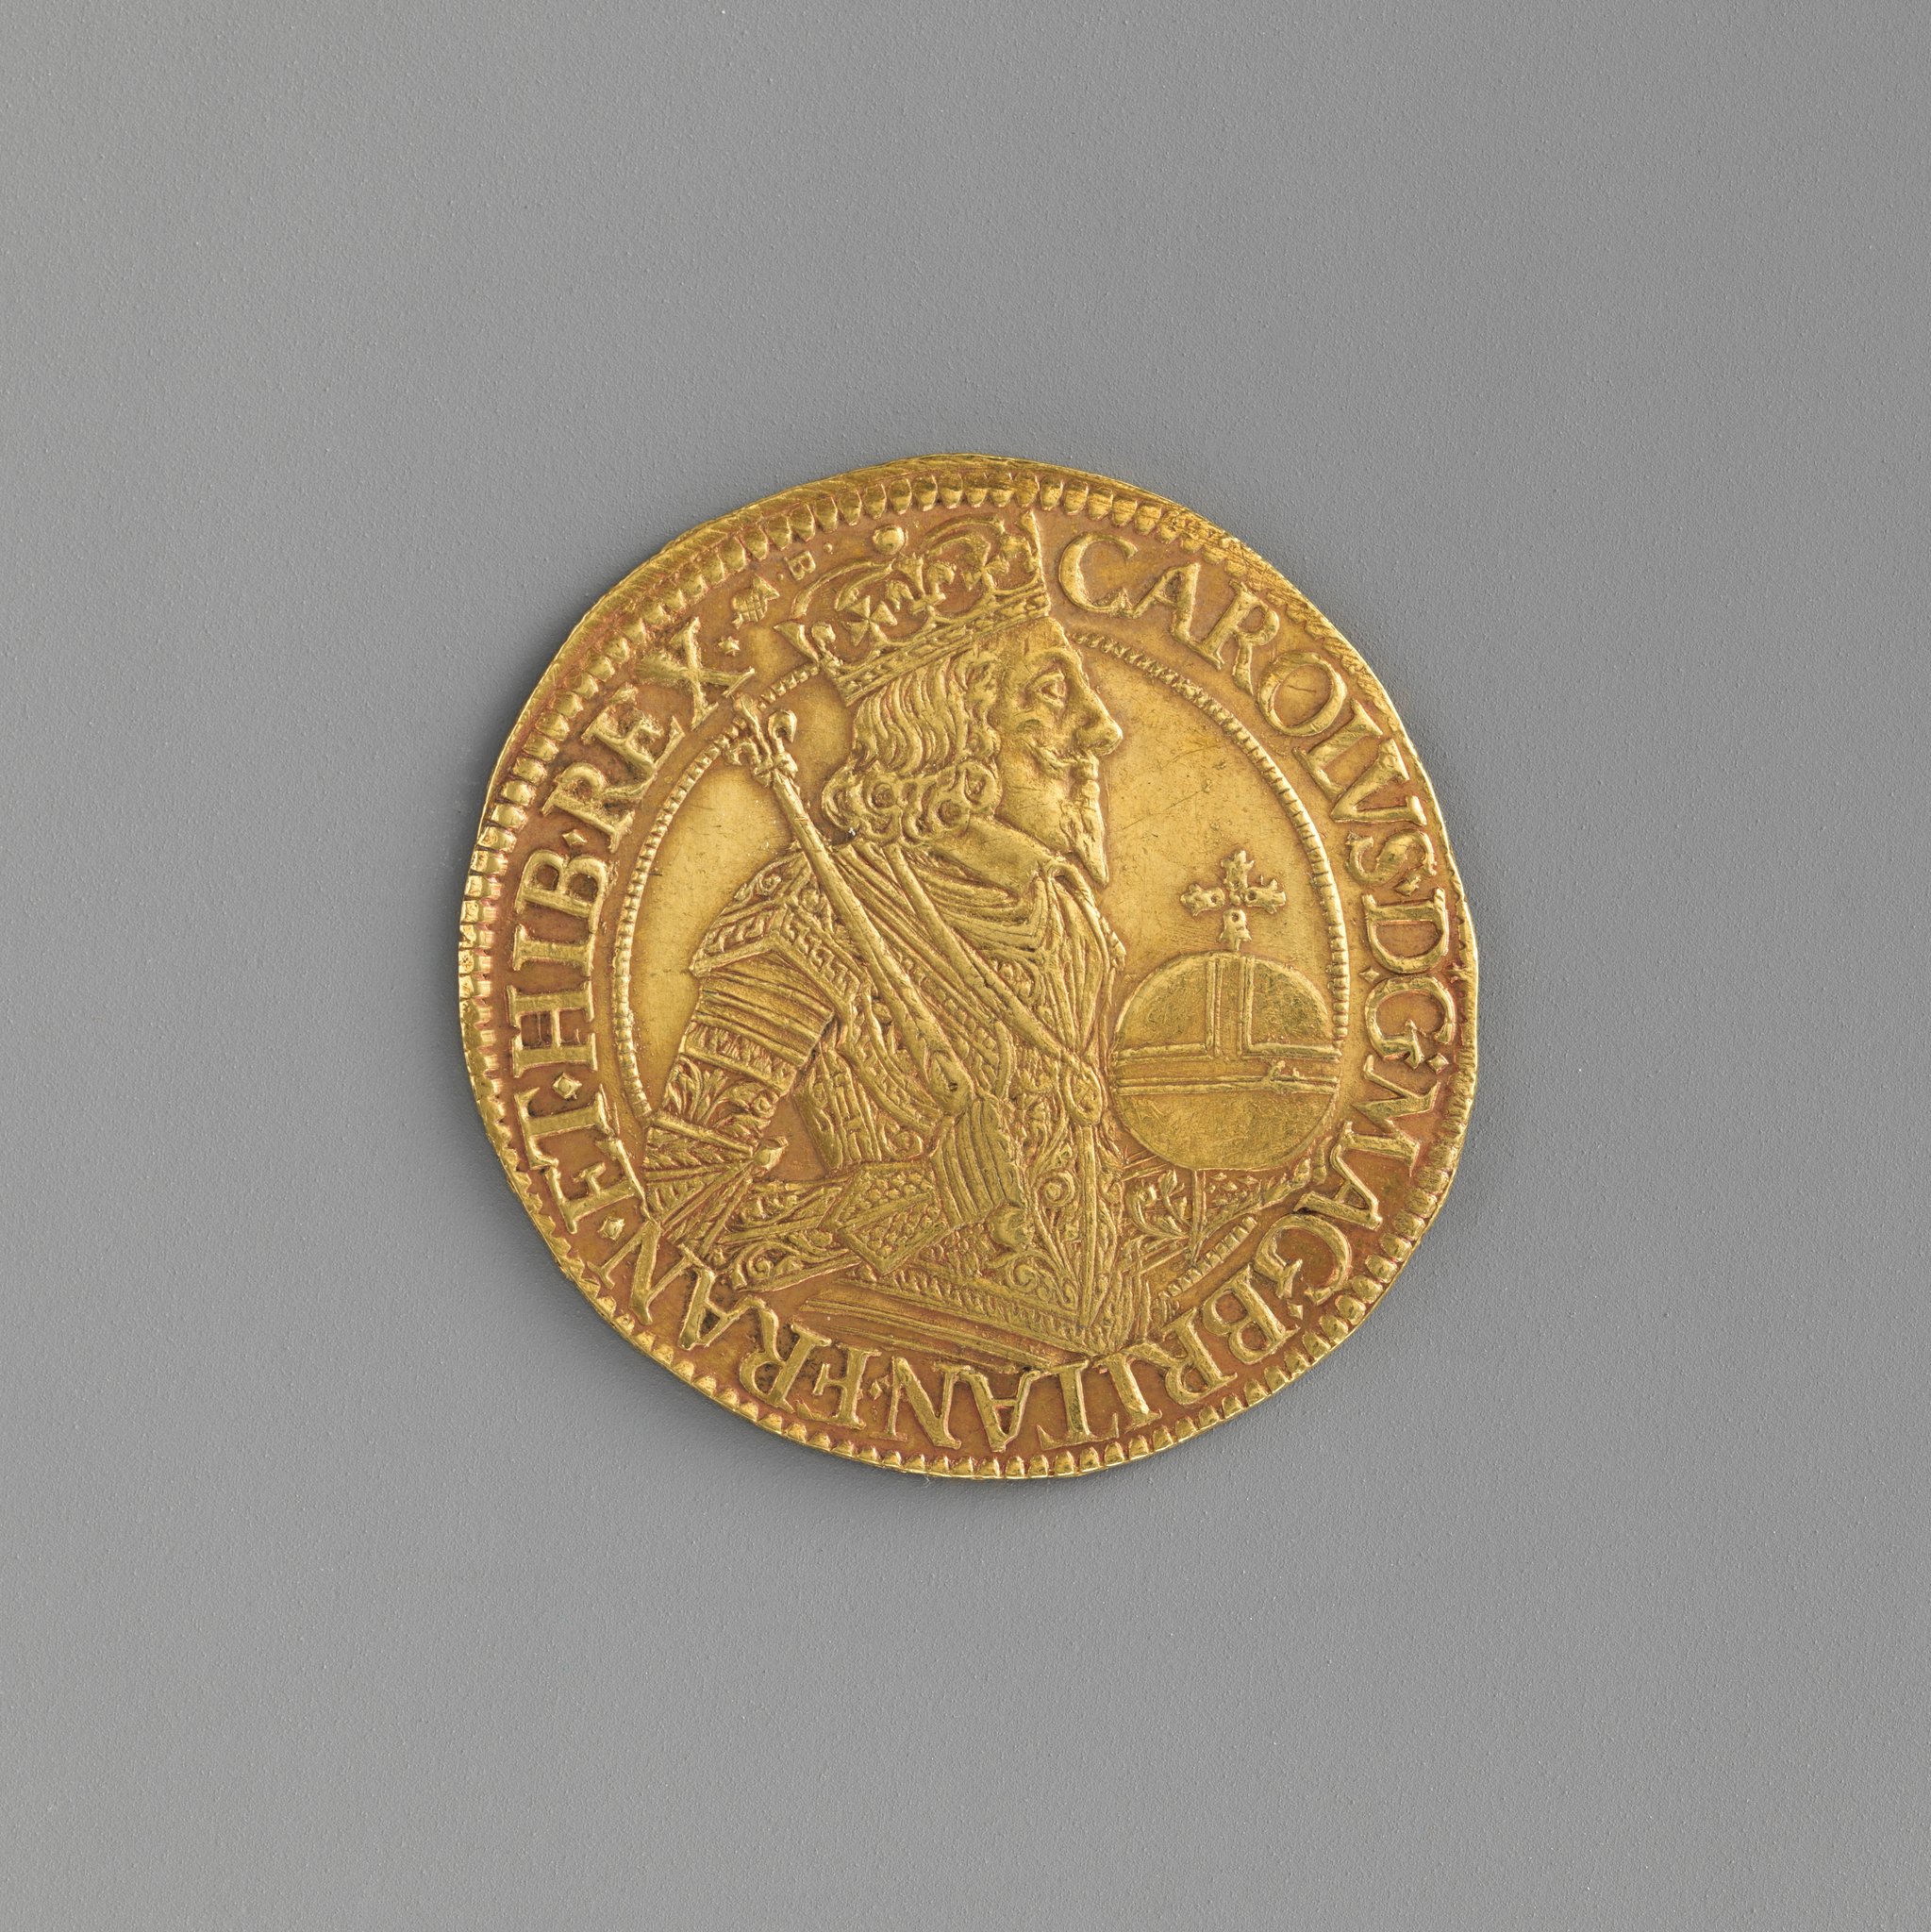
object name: unite coin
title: Unite coin of Charles I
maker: nicholas briot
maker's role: artist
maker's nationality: french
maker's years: 1579-1646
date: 1642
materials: gold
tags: kings,men